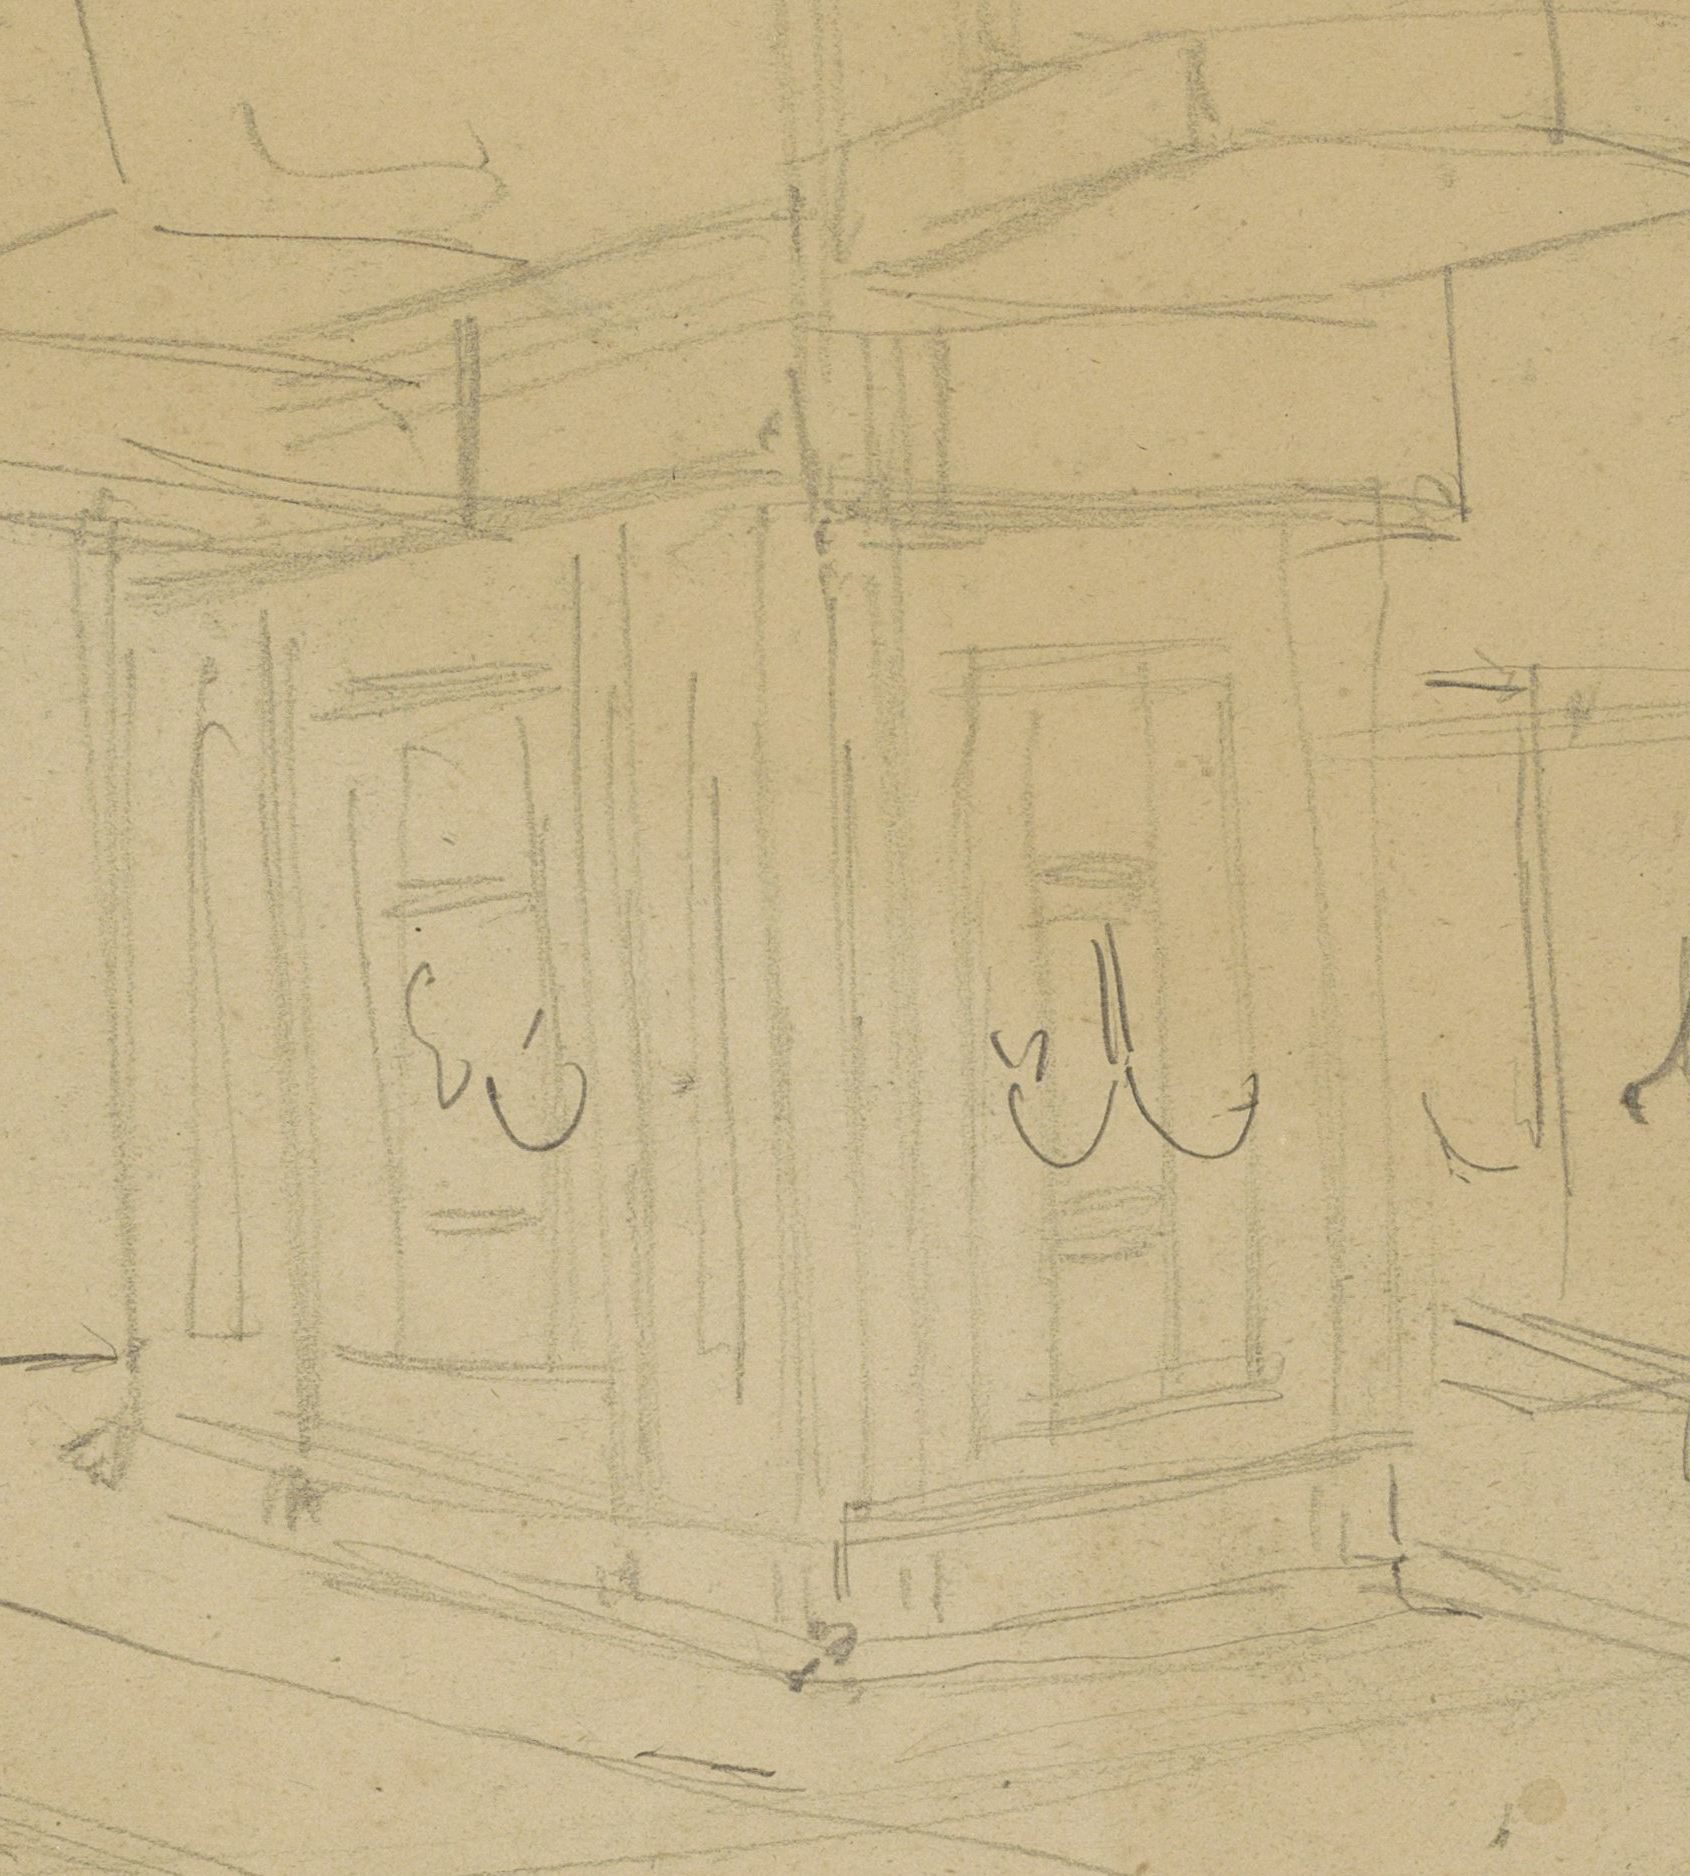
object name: sketchbook leaf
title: Stoelen en een wandbetimmering van het schip 'Grotius'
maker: carel adolph lion cachet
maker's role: draughtsman, print maker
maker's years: 1864-1945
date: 1906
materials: paper, pencil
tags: interior ~ representation of a building, chair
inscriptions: annotation: ‘[...] zilver/ Reguliers[...] lamp/ halve maansteeg/ Bert[...]/ Poggenbeek/ [...]/ prijs van led[...]hen[...]/ [...]’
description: Blad 1 recto uit een schetsboek met 27 bladen.